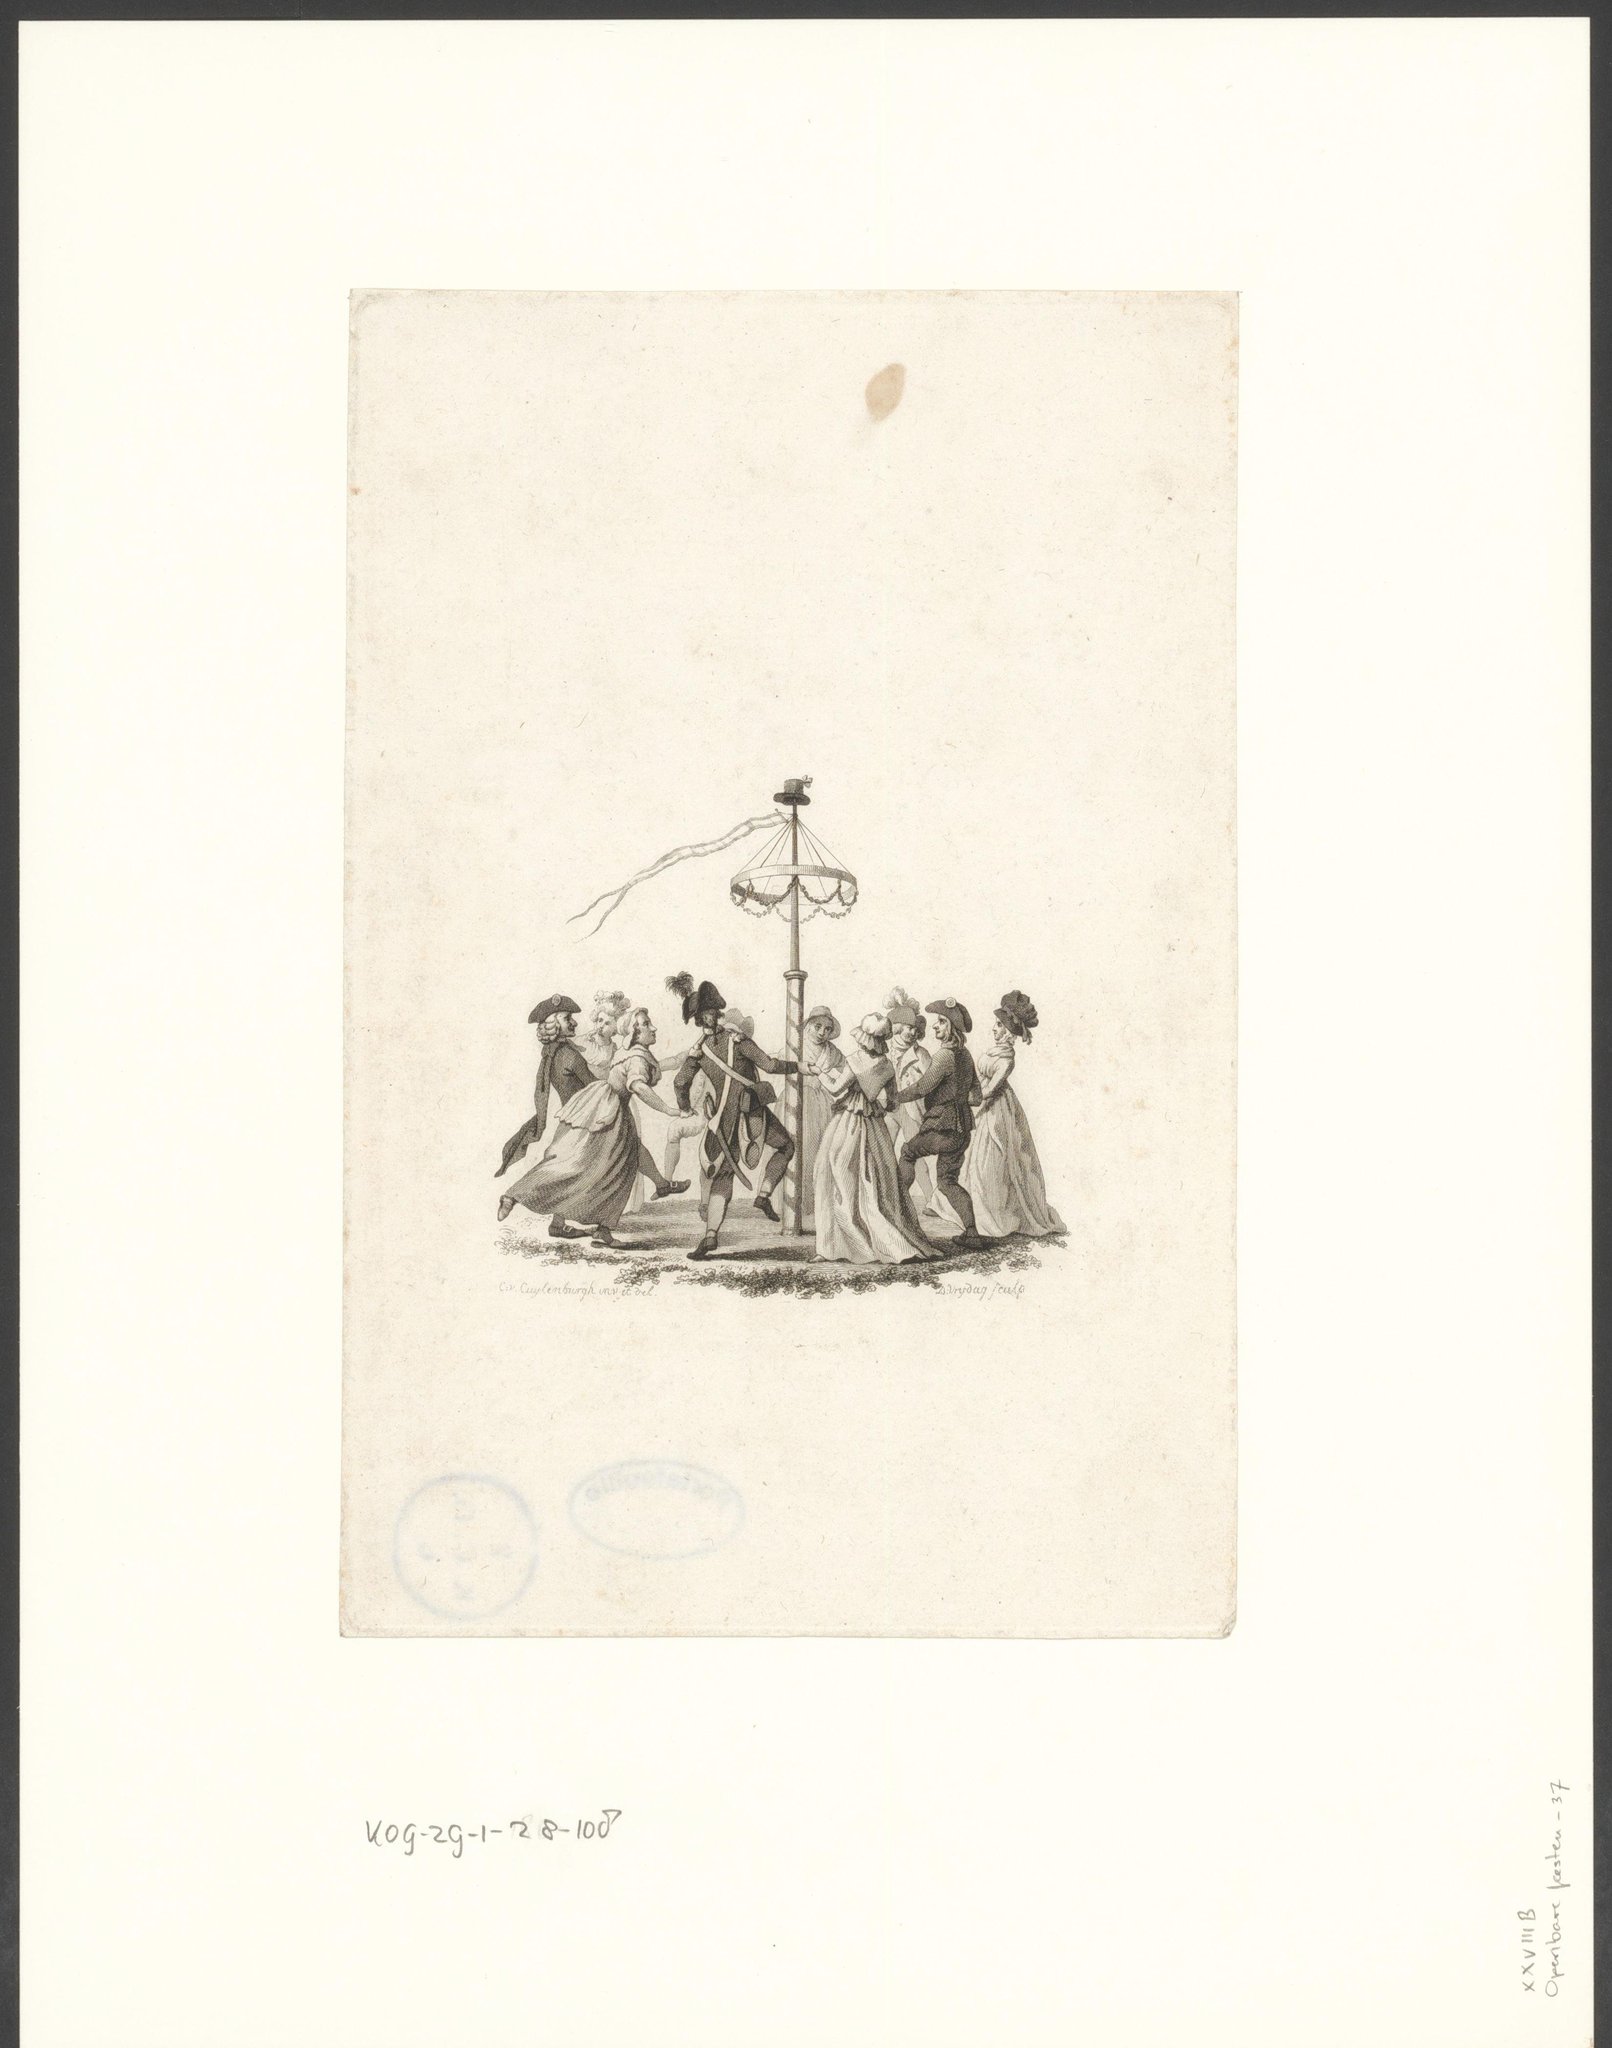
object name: print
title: Dansen om de vrijheidsboom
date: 1799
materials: paper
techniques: etching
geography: the hague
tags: dancing around the tree of liberty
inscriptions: collector's mark: Lugt 1641, stamp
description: Onderwerpsrubrieken binnen de Atlas Zeden en Gewoonten: Zeden en Gewoonten in Engeren Zin. Volksleven. Openbare feesten. Vorstelijke intochten, (Illuminaties, vuurwerken en dergelijke, openbare feesten).